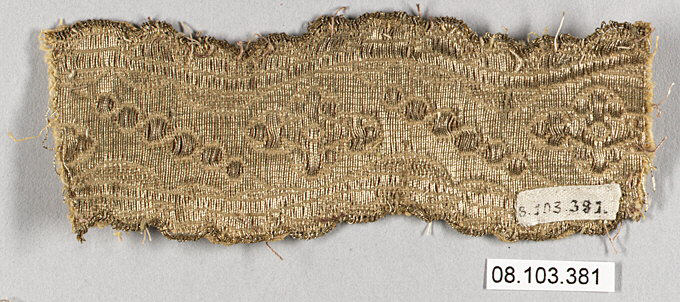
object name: galloon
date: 1601-1800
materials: metal thread